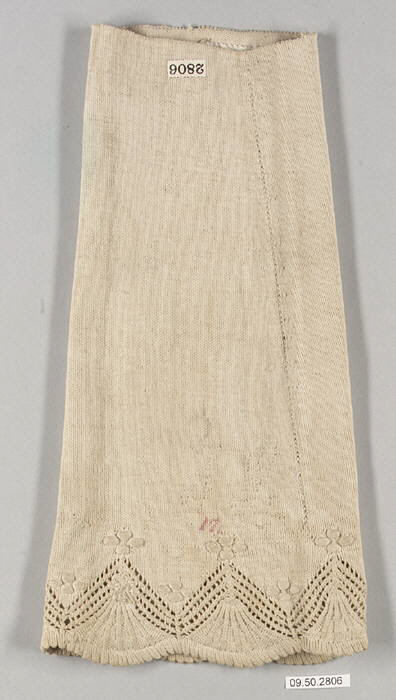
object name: stocking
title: Stocking leg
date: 1801-1900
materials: lace